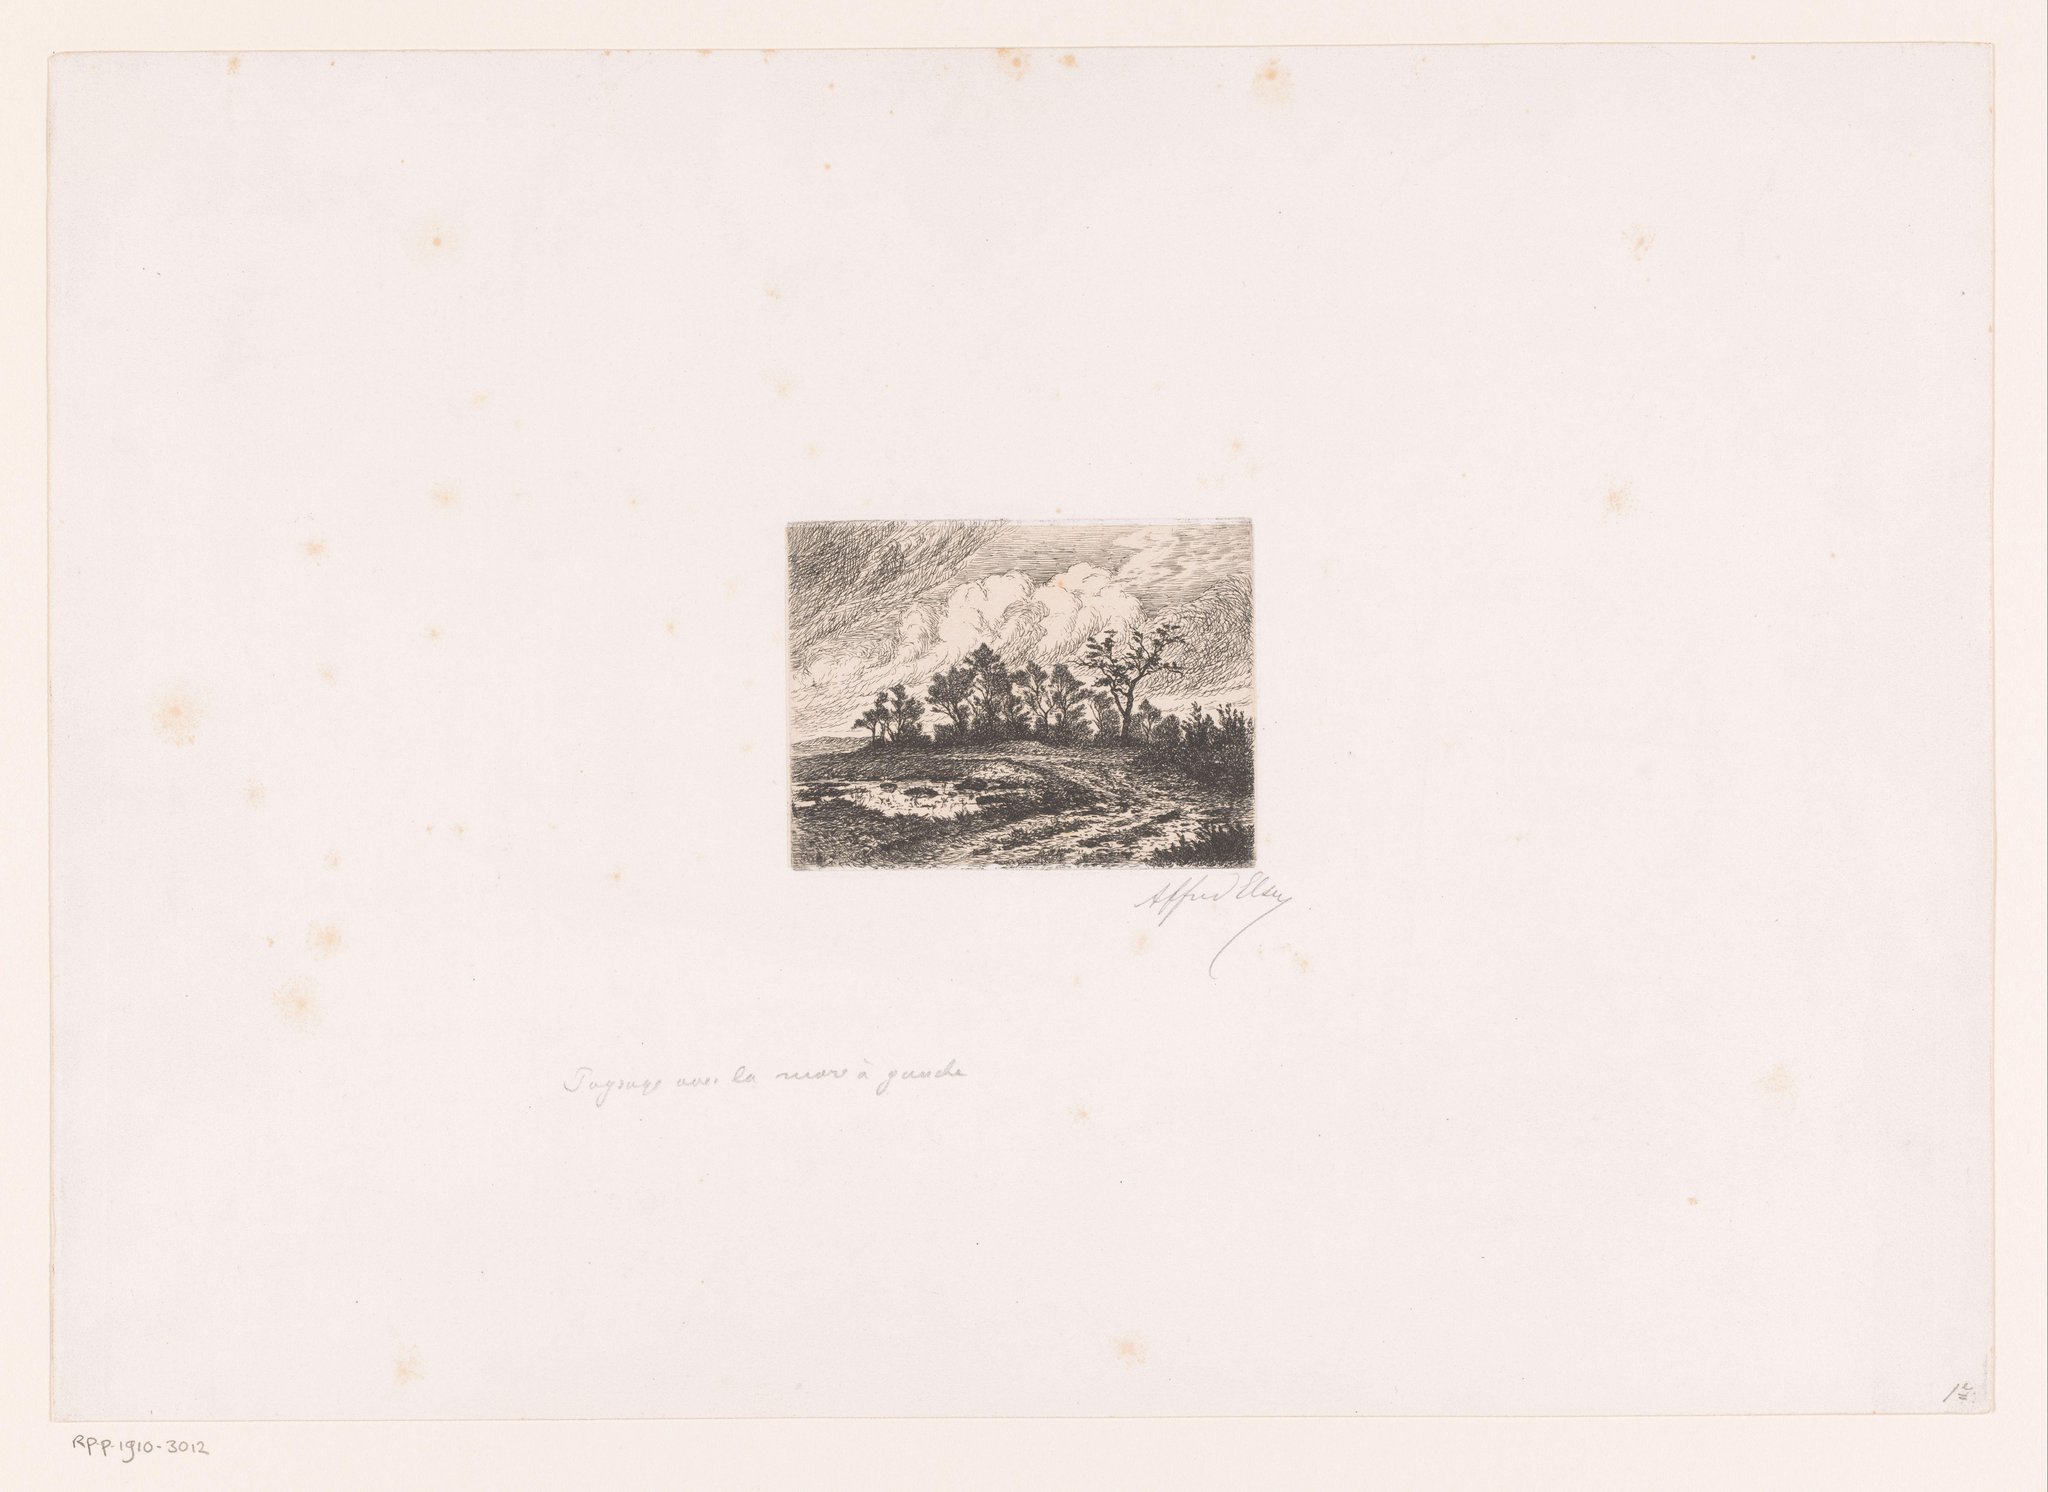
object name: print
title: Landschap met links een poel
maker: alfred elsen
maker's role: painter, print maker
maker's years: 1850-1914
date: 1860-1910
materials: paper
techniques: etching, intaglio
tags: lake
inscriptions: collector's mark: Lugt 2228